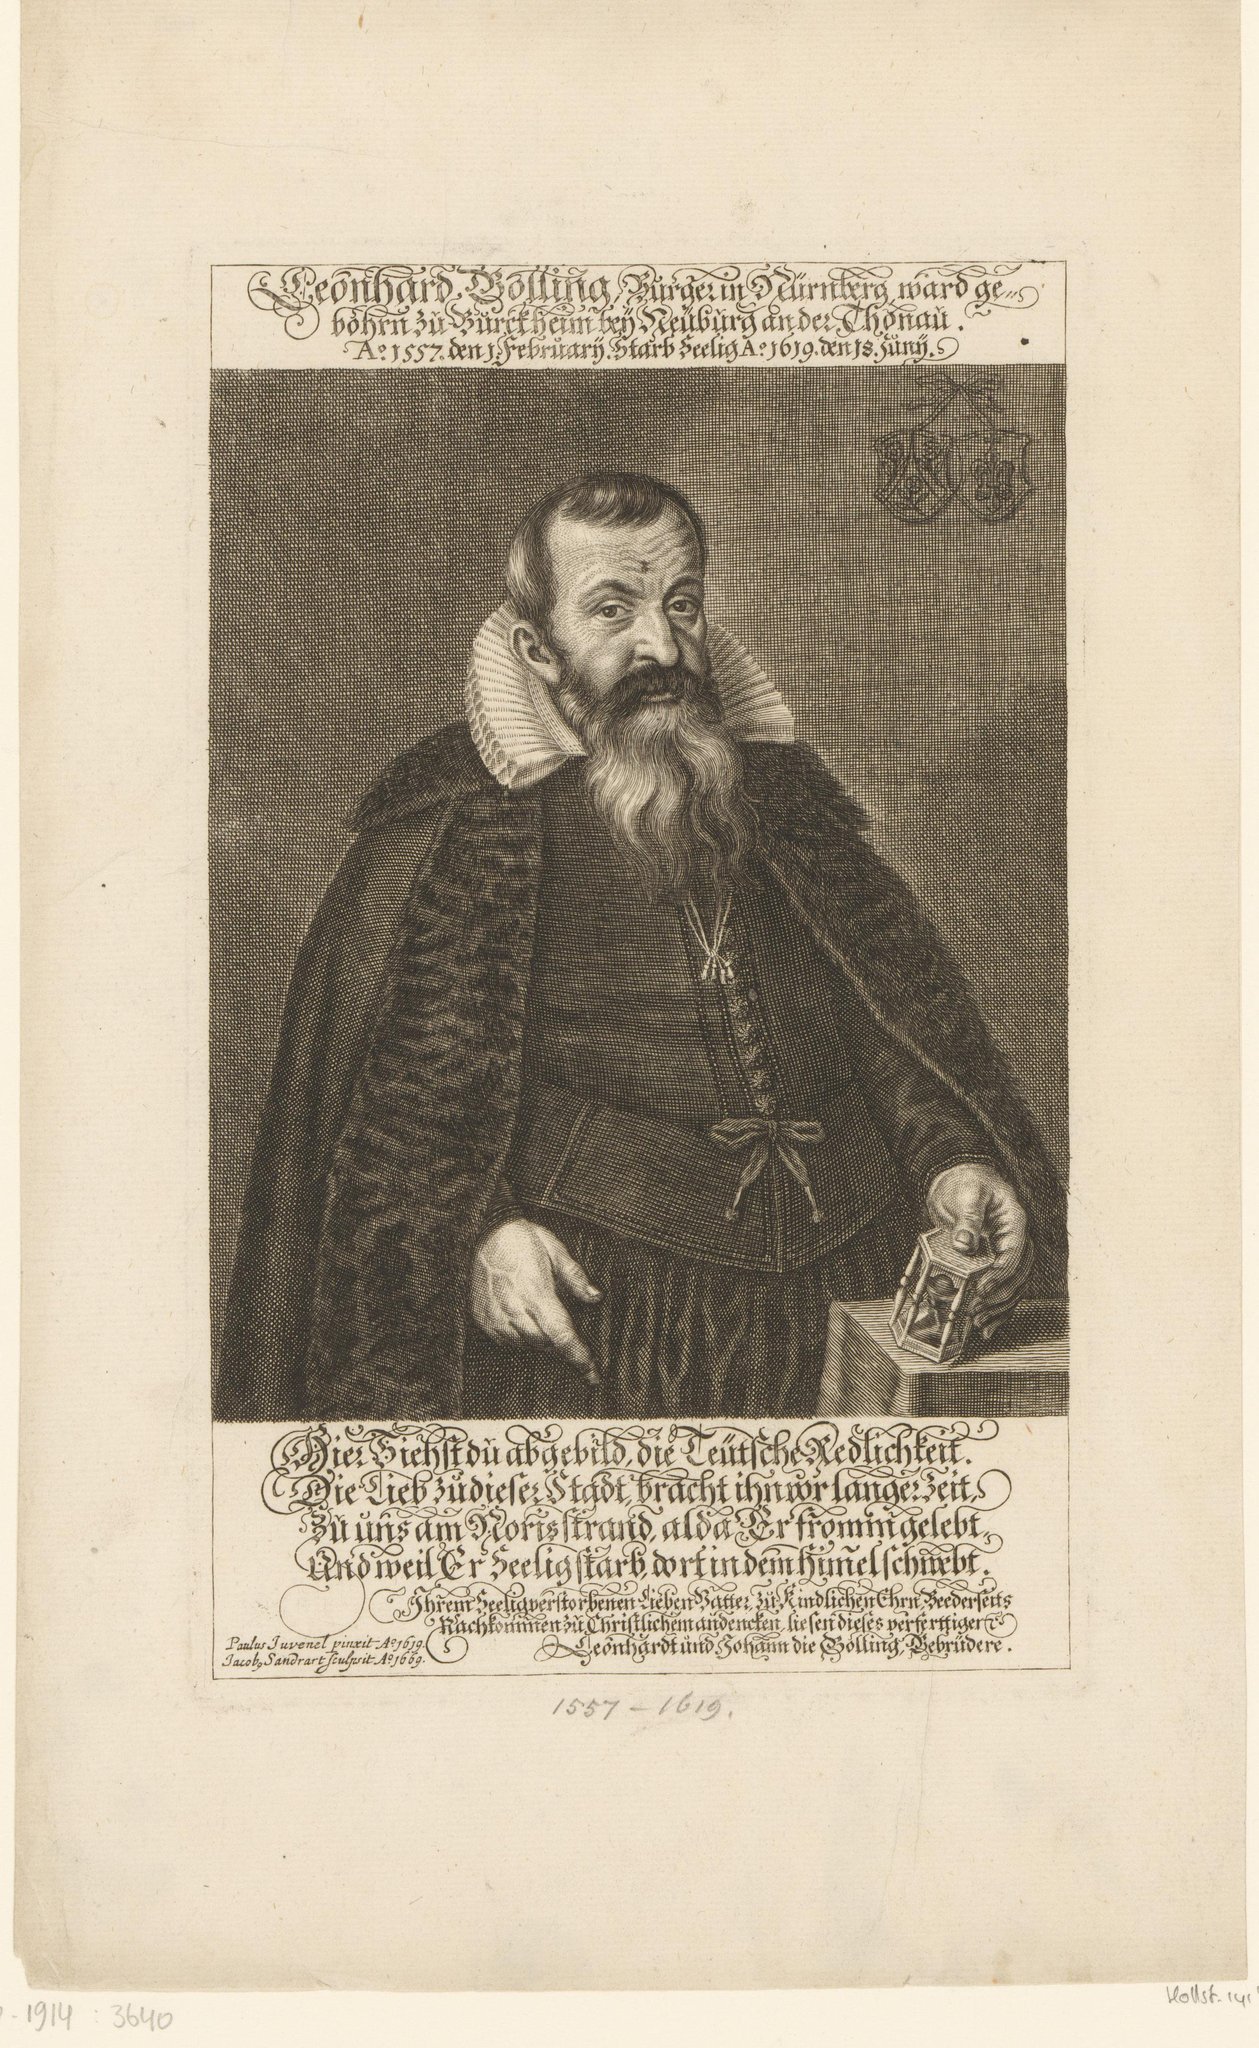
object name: print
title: Portret van Leonhard Golling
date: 1669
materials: paper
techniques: engraving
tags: painter, historical persons, hourglass, armorial bearing, heraldry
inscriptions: collector's mark: Lugt 2228, date